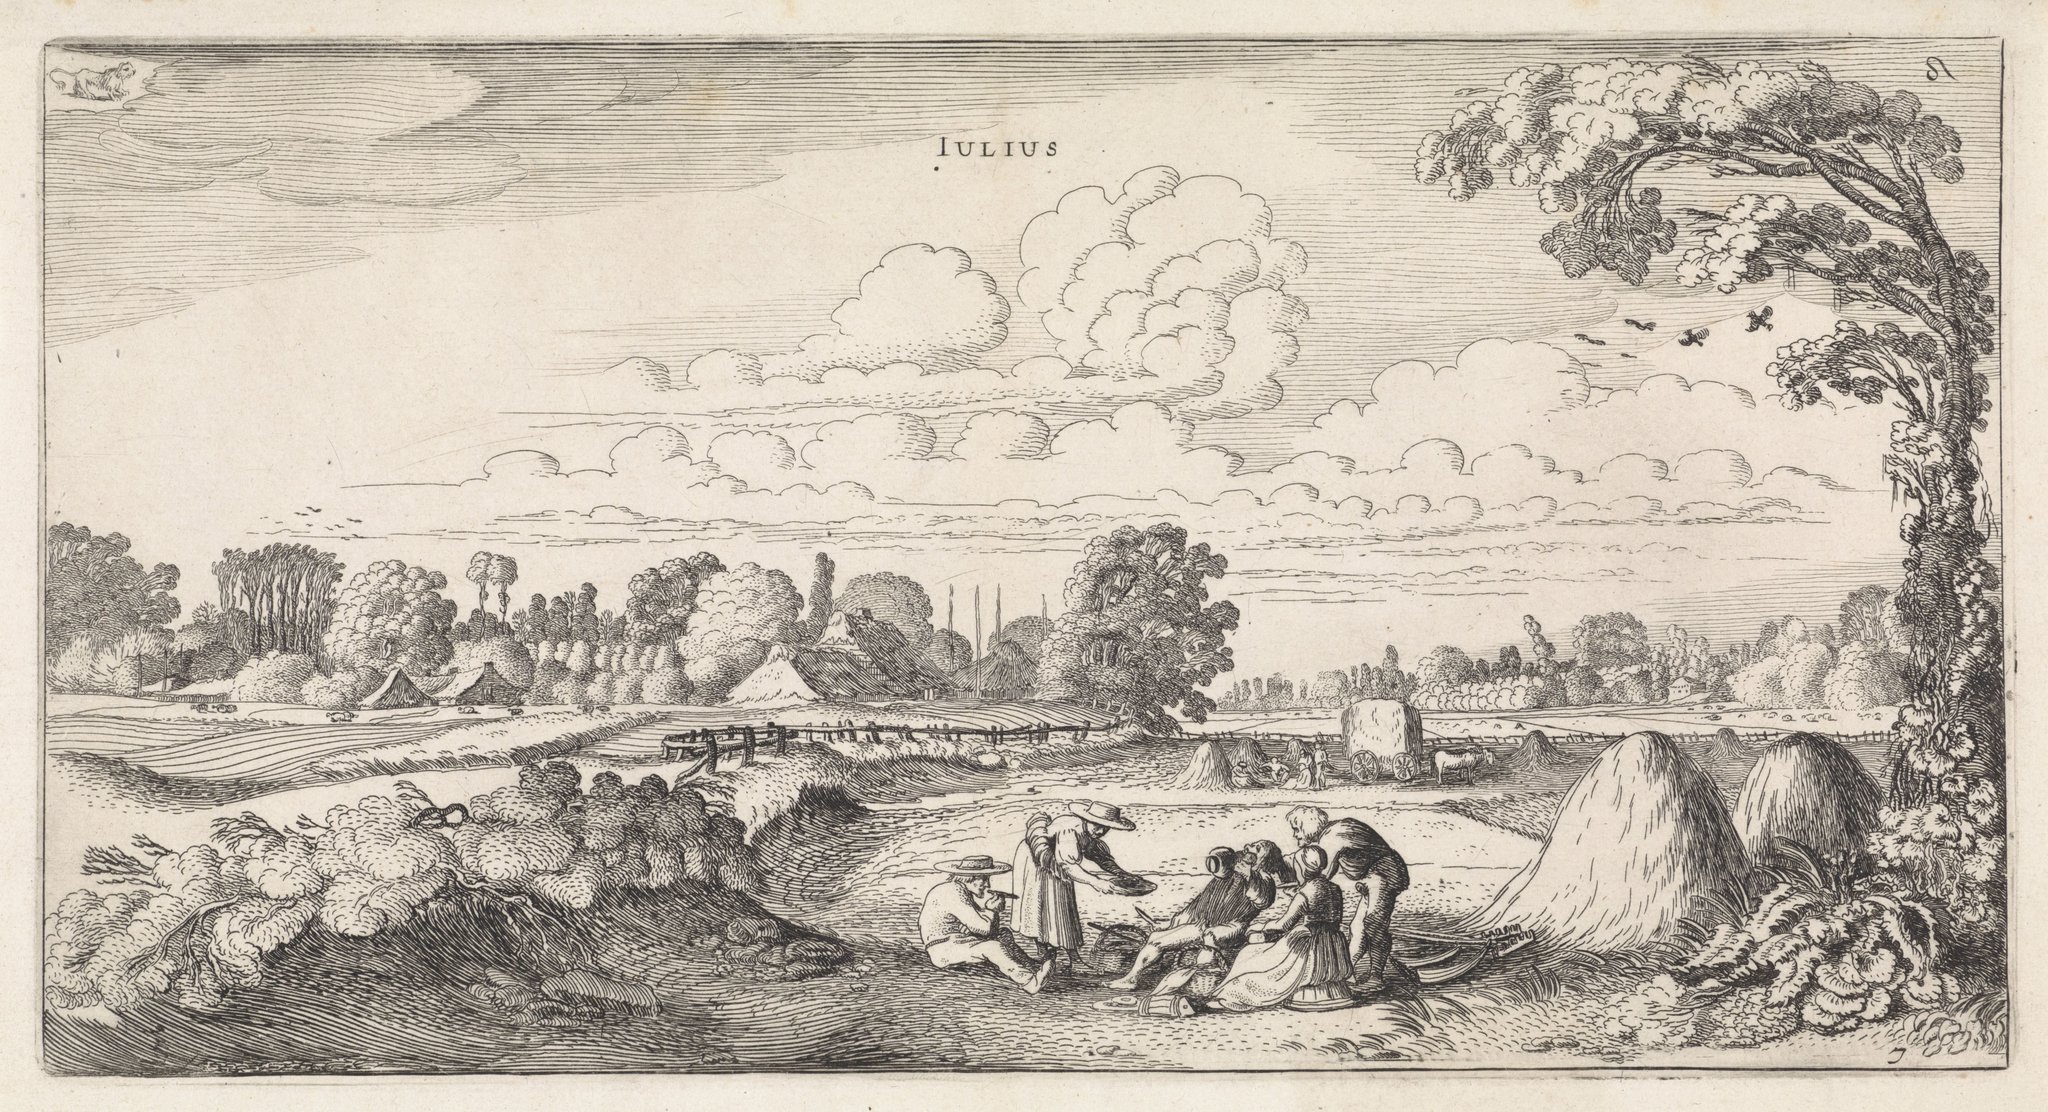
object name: print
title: Juli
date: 1616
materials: paper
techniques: etching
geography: northern netherlands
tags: july and its 'labours', leo (zodiacal sign of july), hay-stack, hay-wagon, rest during harvest (eating, dancing, making love, etc.), landscape symbolizing july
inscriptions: collector's mark: Lugt 240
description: Een landschap met rustende en etende boeren tijdens het hooien, voorstellende de maand juli. Links- en rechtsboven de bij deze maand behorende symbolen van het sterrenbeeld leeuw. Zevende prent uit een serie van twaalf.